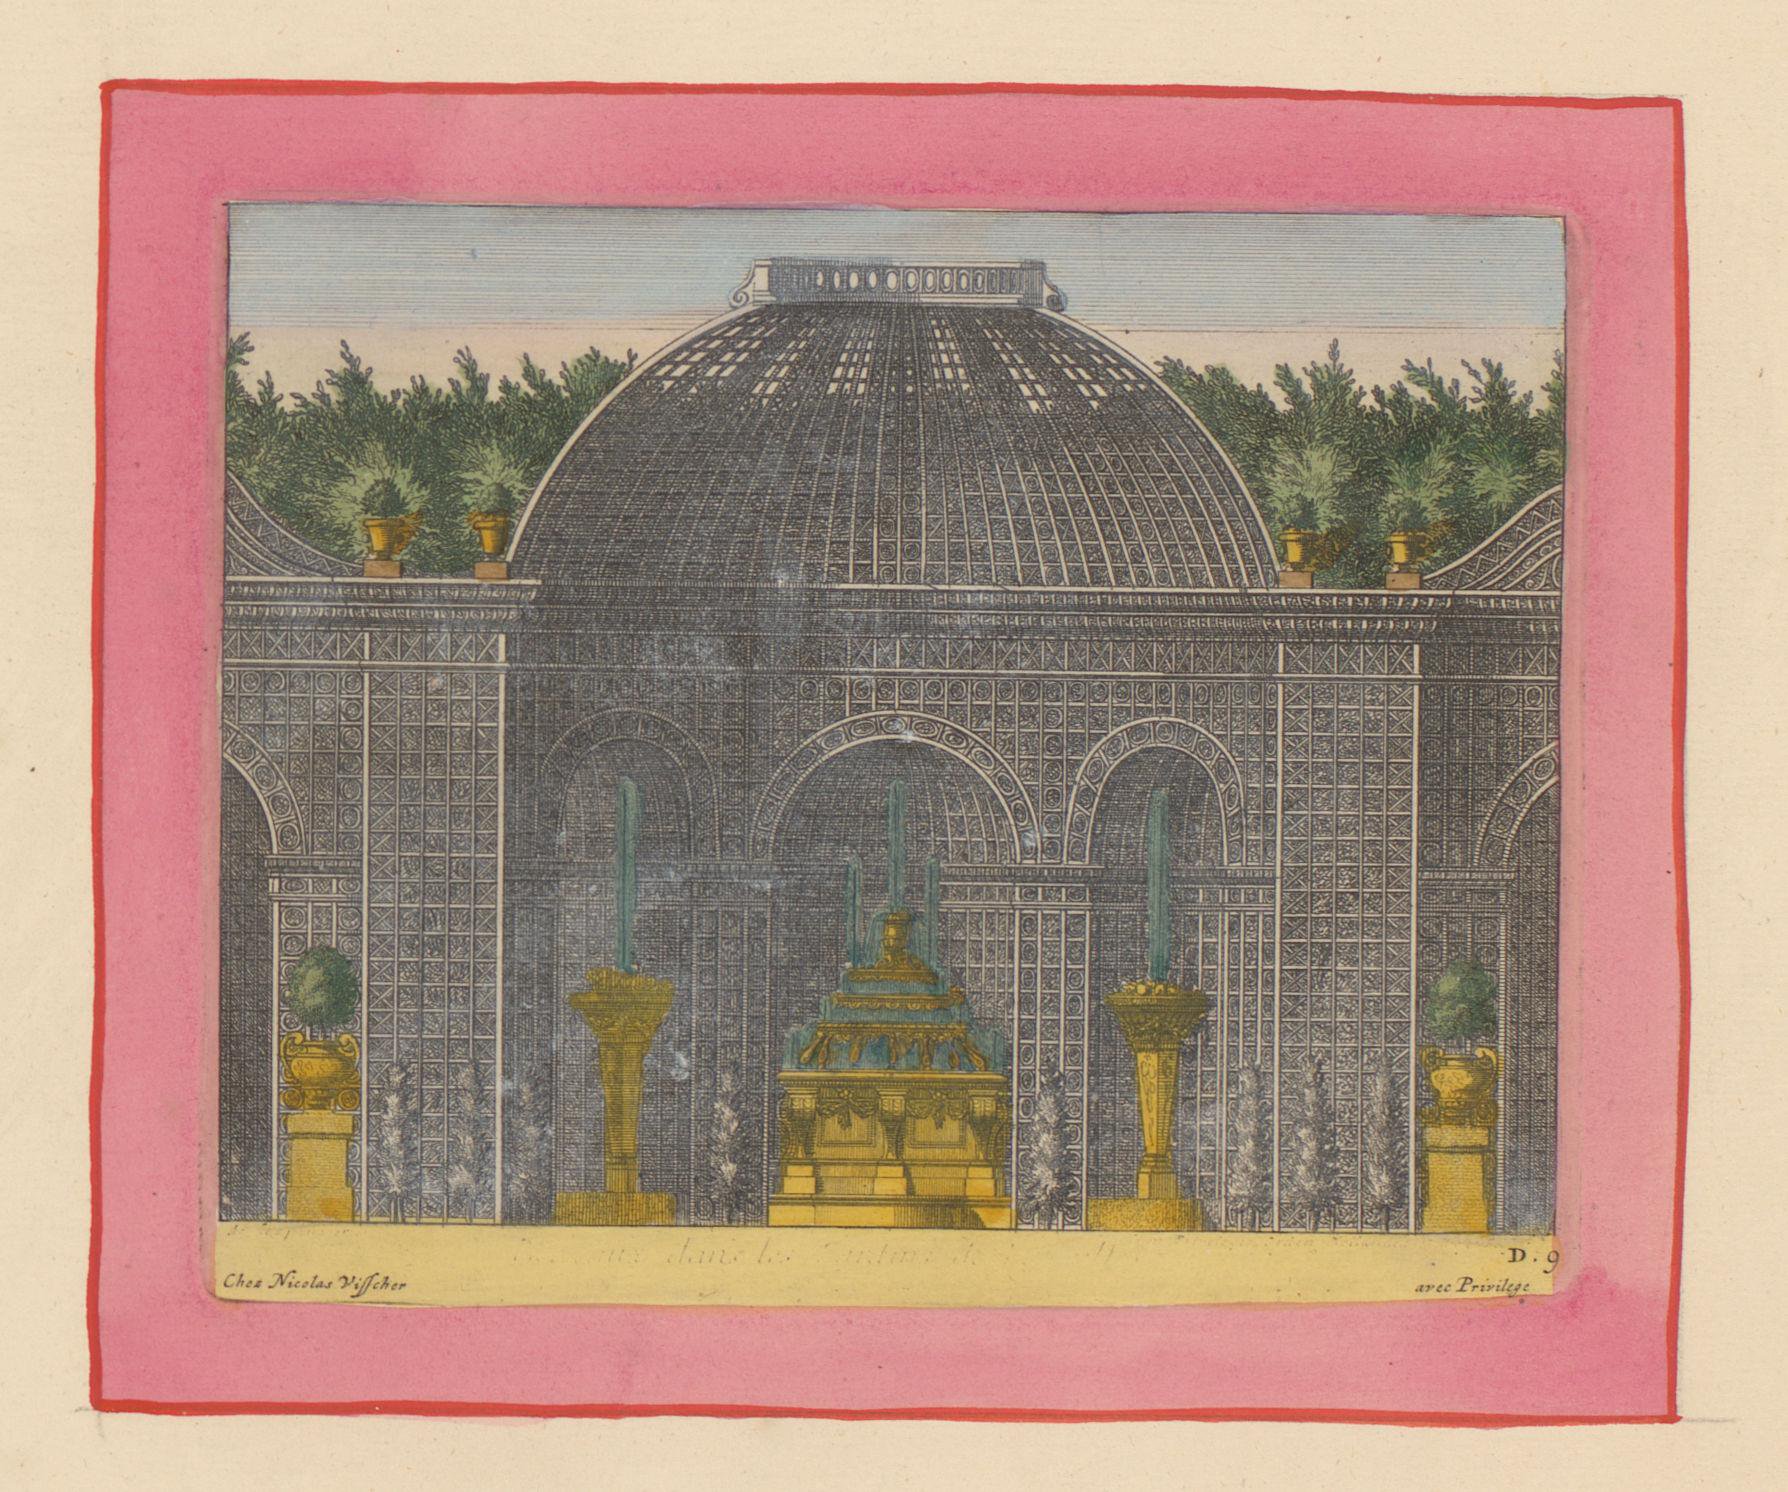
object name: print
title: Veues de Versailles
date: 1686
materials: paper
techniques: etching, hand coloring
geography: amsterdam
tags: trellis, french or architectonic garden; formal garden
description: Prieel van latwerk met in de nissen fonteinen in de tuinen van Versailles. Rechtsonder het serienummer: D9. Prent maakt deel uit van een album.